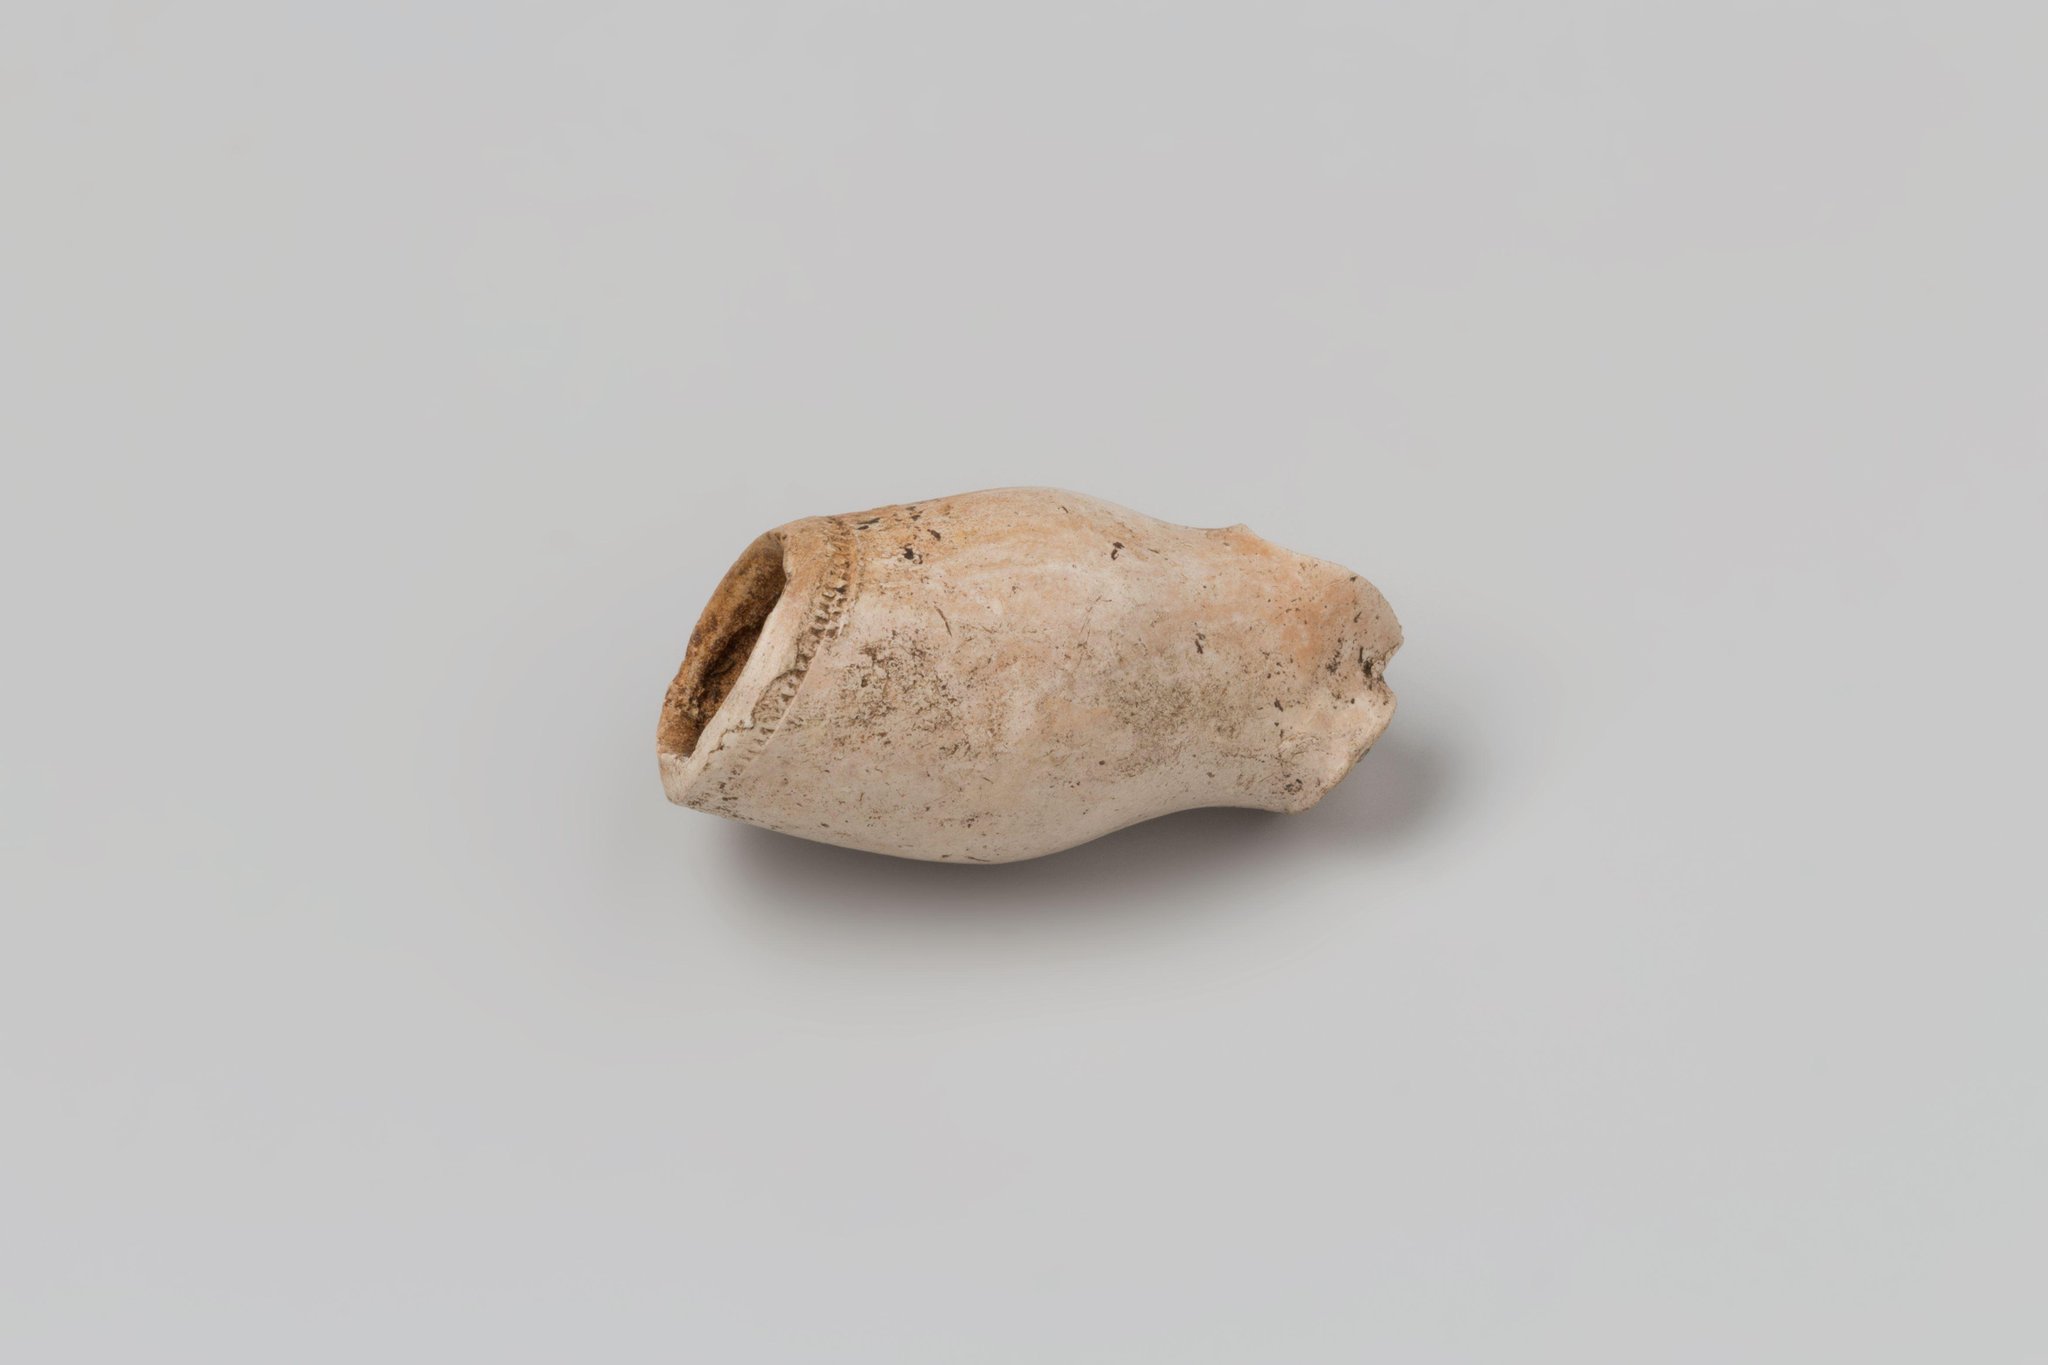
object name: pipe bowl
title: Pijpenkop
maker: Anonymous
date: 1400-1950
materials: clay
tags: zeeuwsche uytkyck